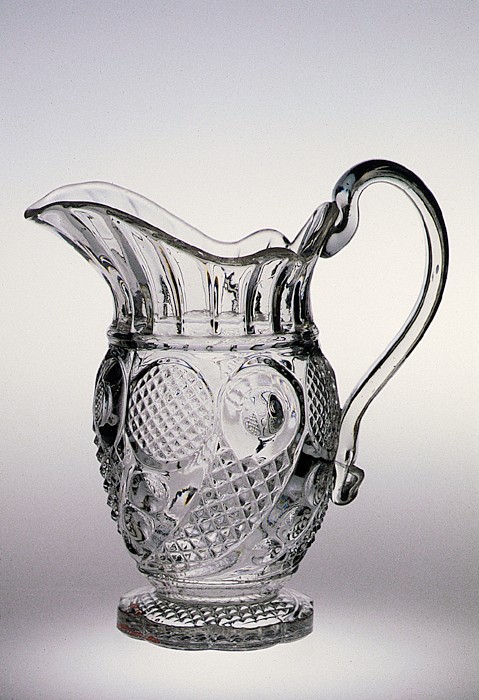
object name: pitcher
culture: american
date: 1850-1870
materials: glass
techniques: pressed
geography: united states